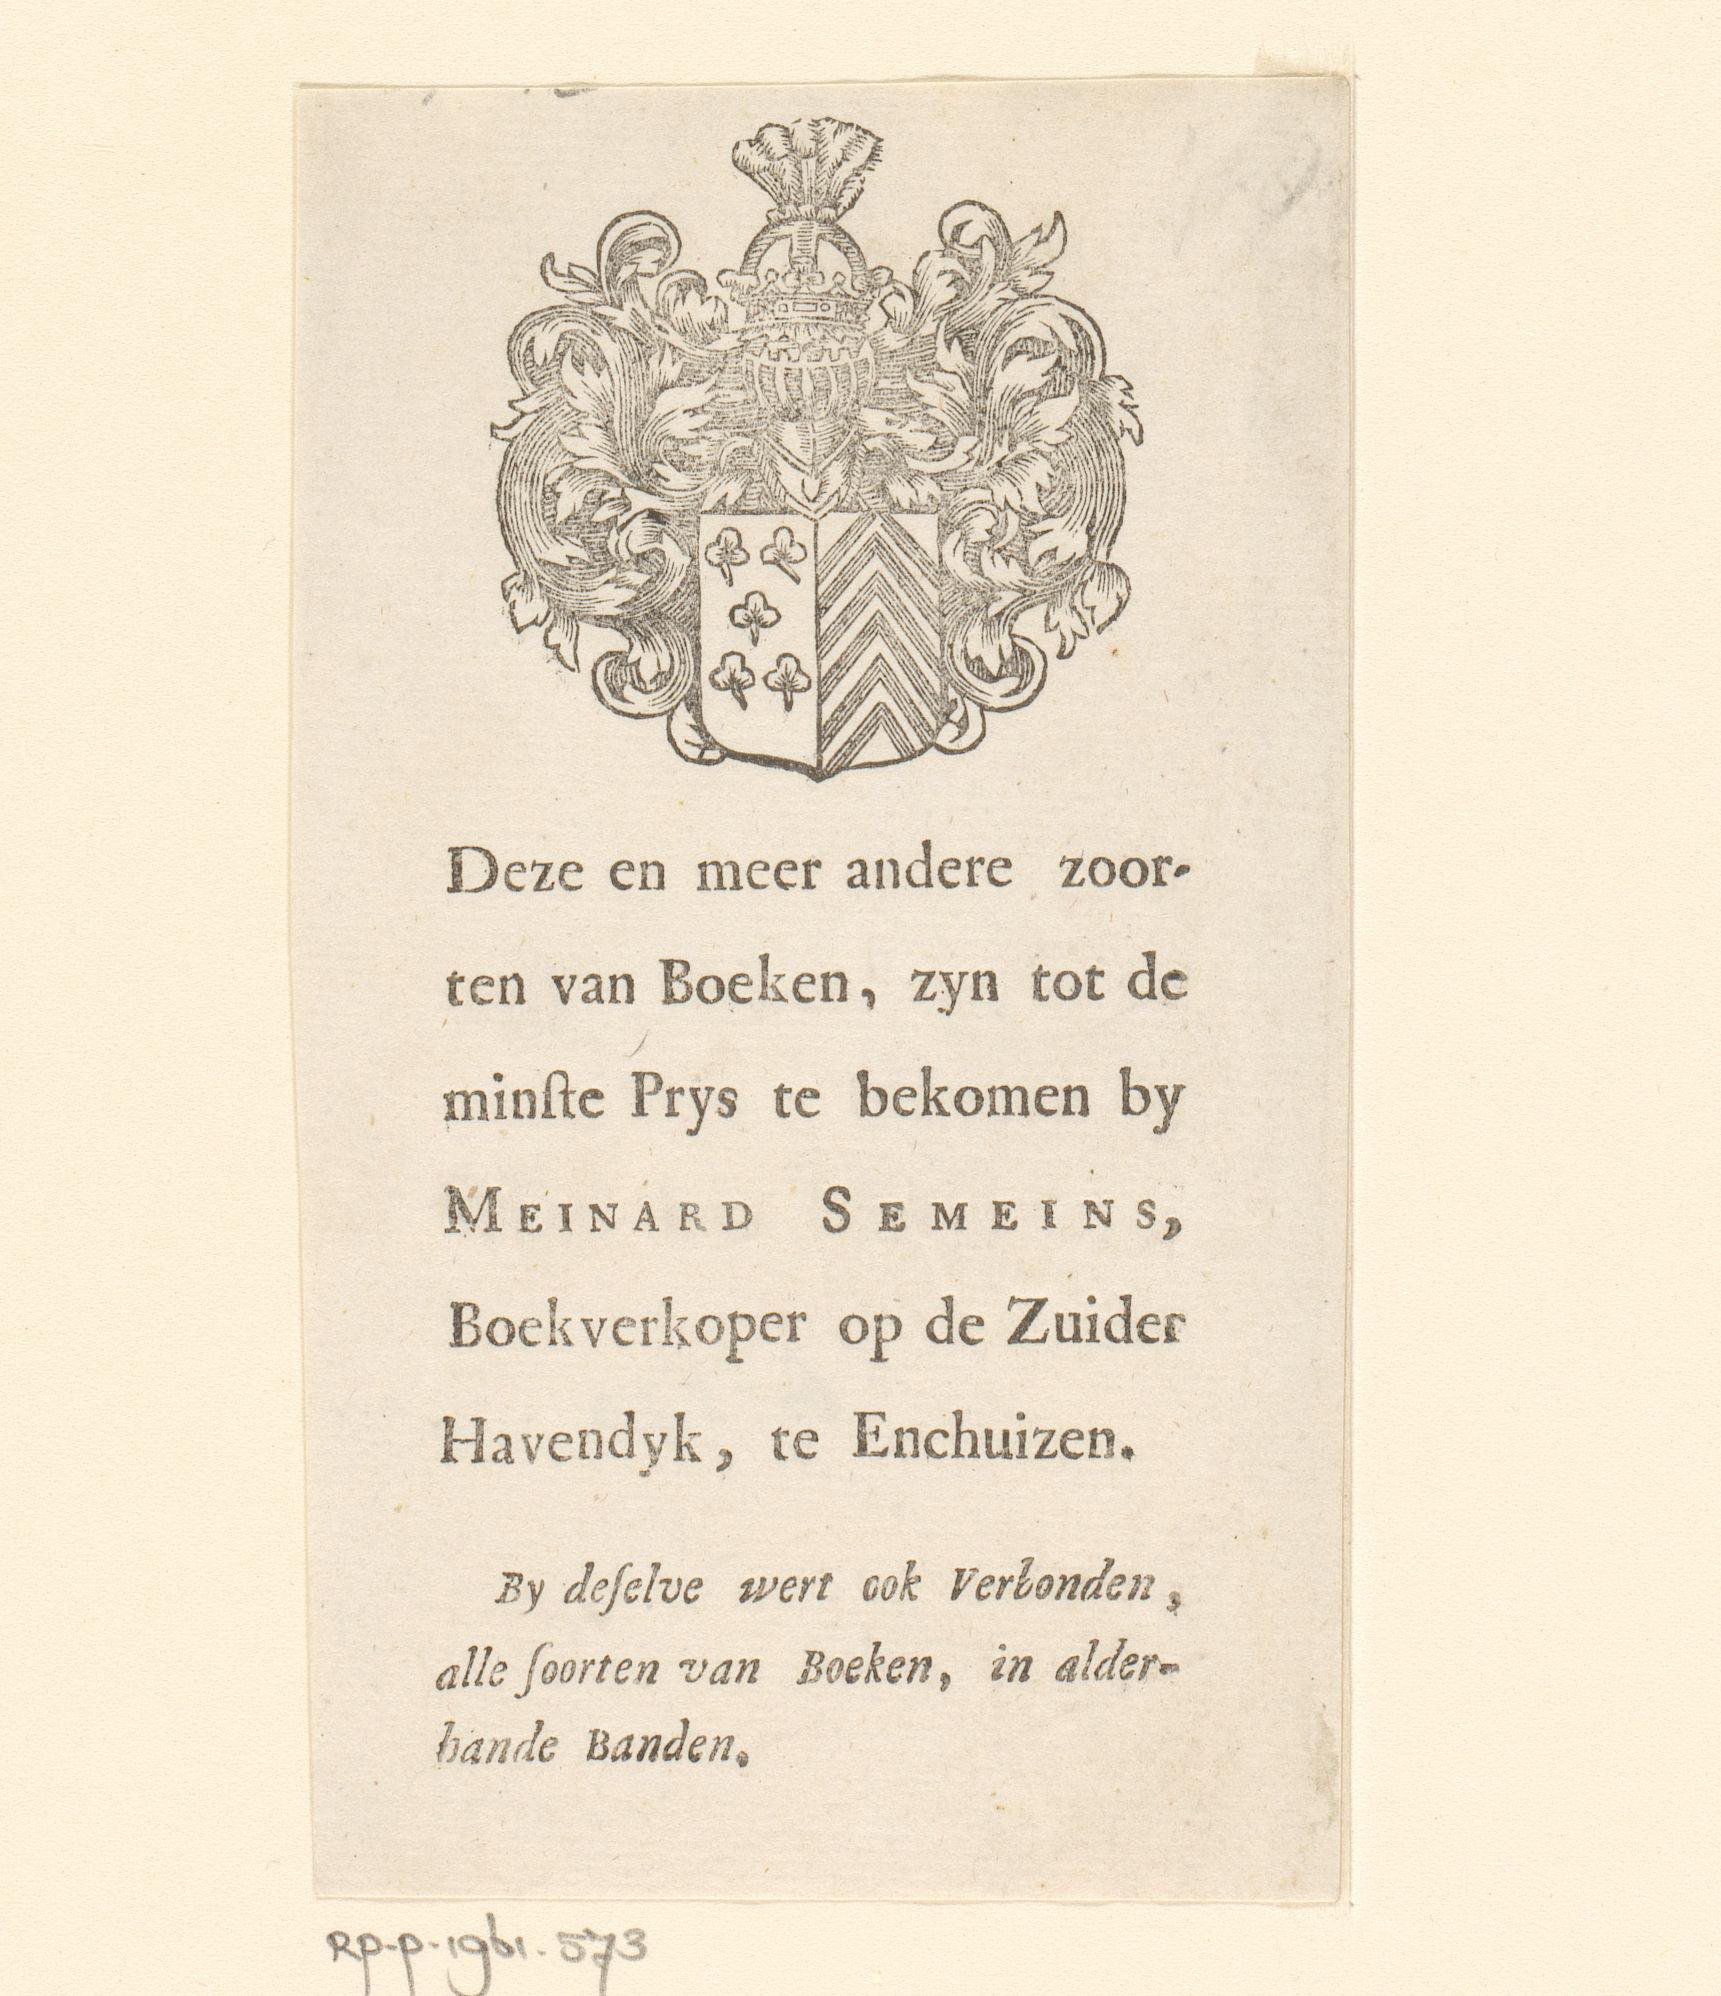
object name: advertisement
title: Advertentie van boekhandelaar Meindert Semeyns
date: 1730-1786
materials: paper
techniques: letterpress printing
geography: enkhuizen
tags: printer, meindert semeyns, coat of arms (as symbol of the state, etc.), advertisement, notice, enkhuizen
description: Bovenaan een wapenschild. Daaronder: 'Deze en meer andere zoorten van Boeken, zyn tot de minste Prys te bekomen bij Meinart Semeins, Boekverkoper op de Zuider Havendyk, te Enchuizen. Bij deselve werd ook Verbonden alle soorten van Boeken, in alderhande Banden'.